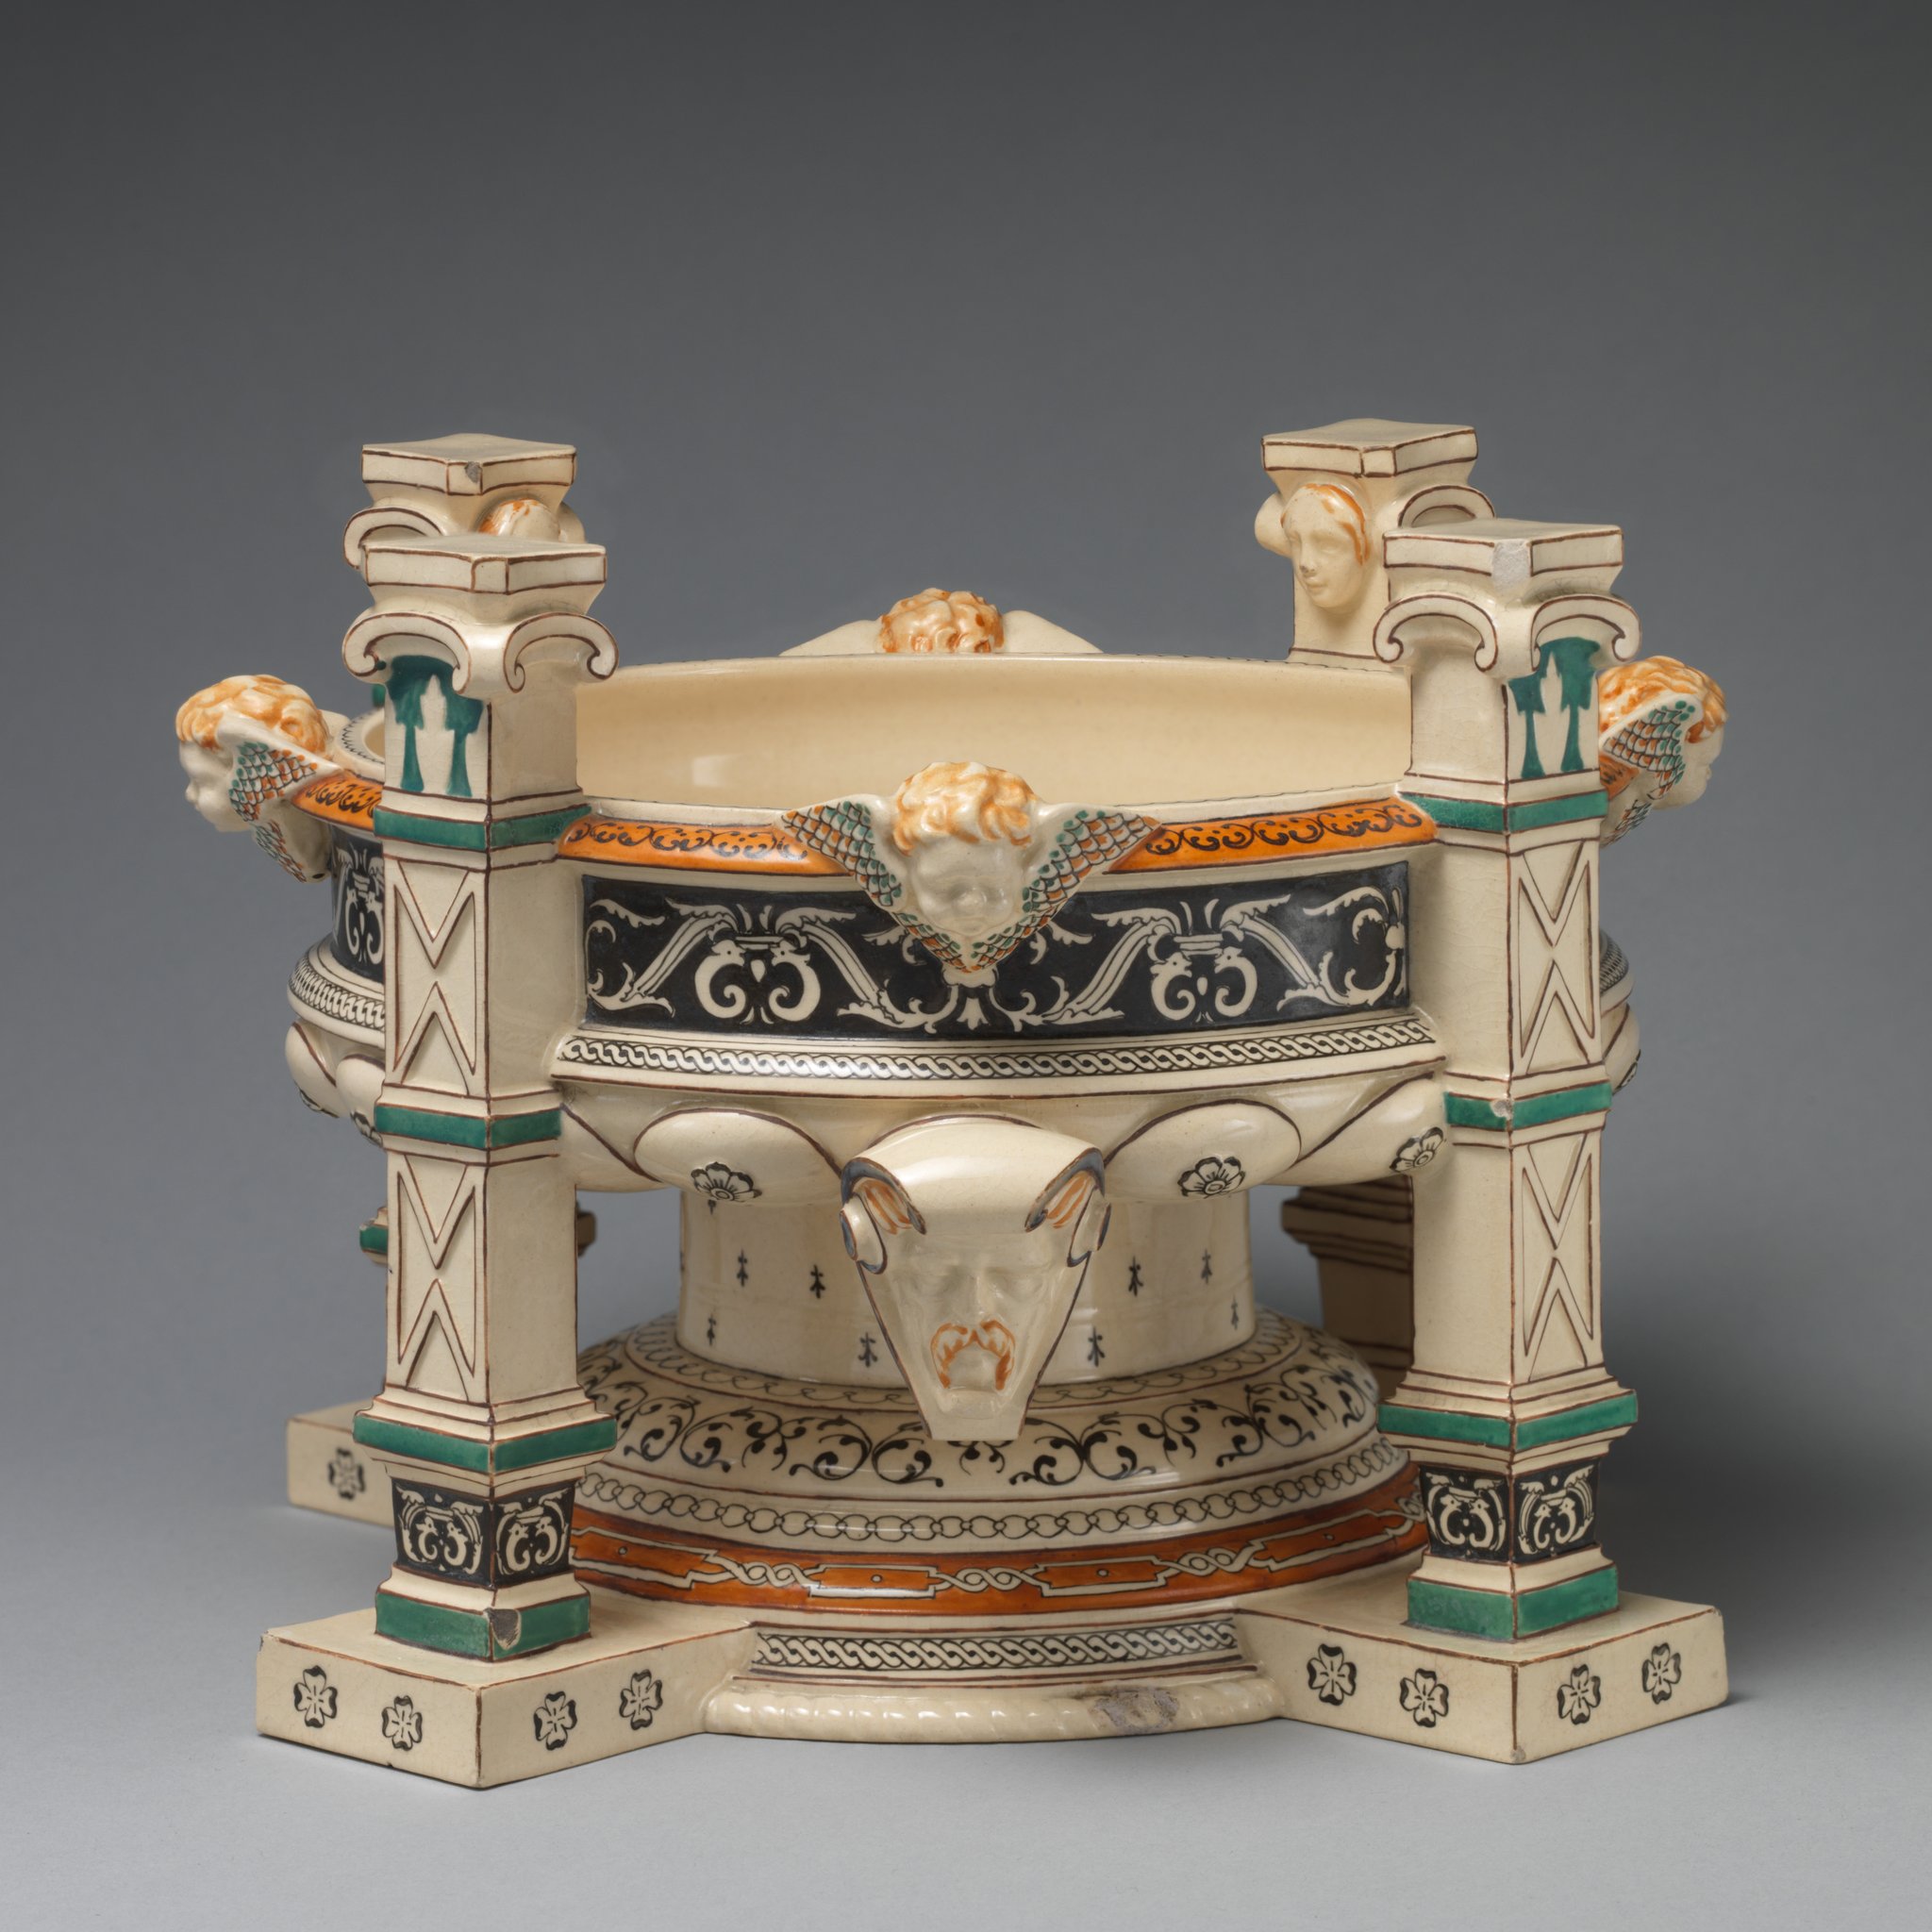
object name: basin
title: Standing Basin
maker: worcester factory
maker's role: maker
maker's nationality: british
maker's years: 1751-2008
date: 1865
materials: earthenware, enamel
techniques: glazing